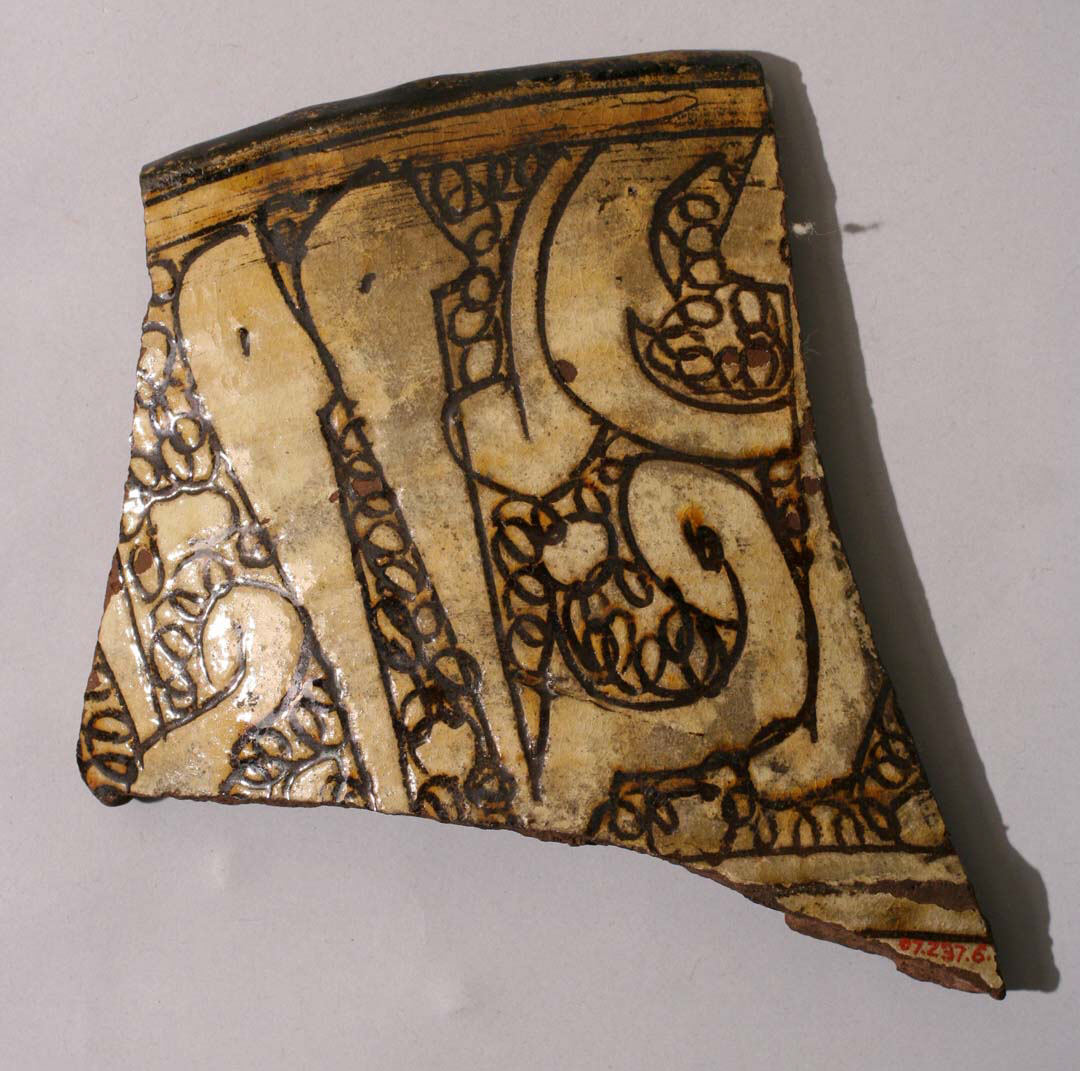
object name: fragment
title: Ceramic Fragment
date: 1301-1500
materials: earthenware, glaze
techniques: coloring, incising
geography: egypt